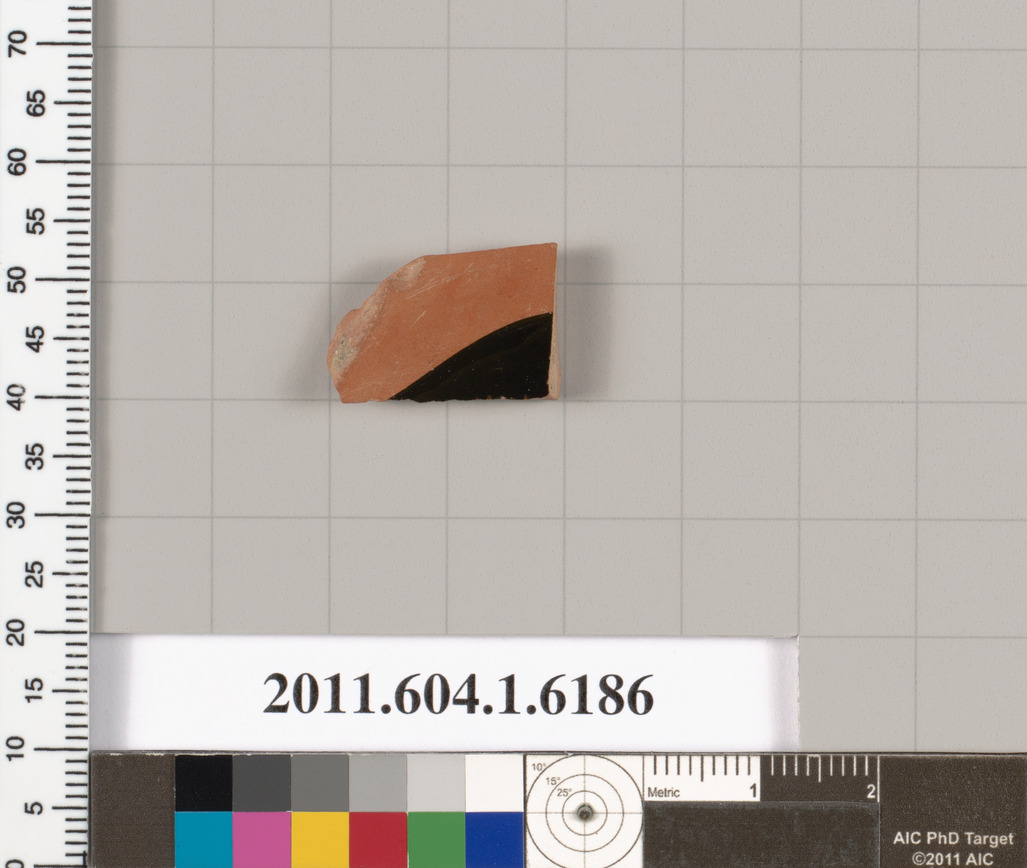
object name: kylix fragment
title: Terracotta fragment of a kylix (drinking cup)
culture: greek, attic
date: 520-500 BCE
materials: terracotta